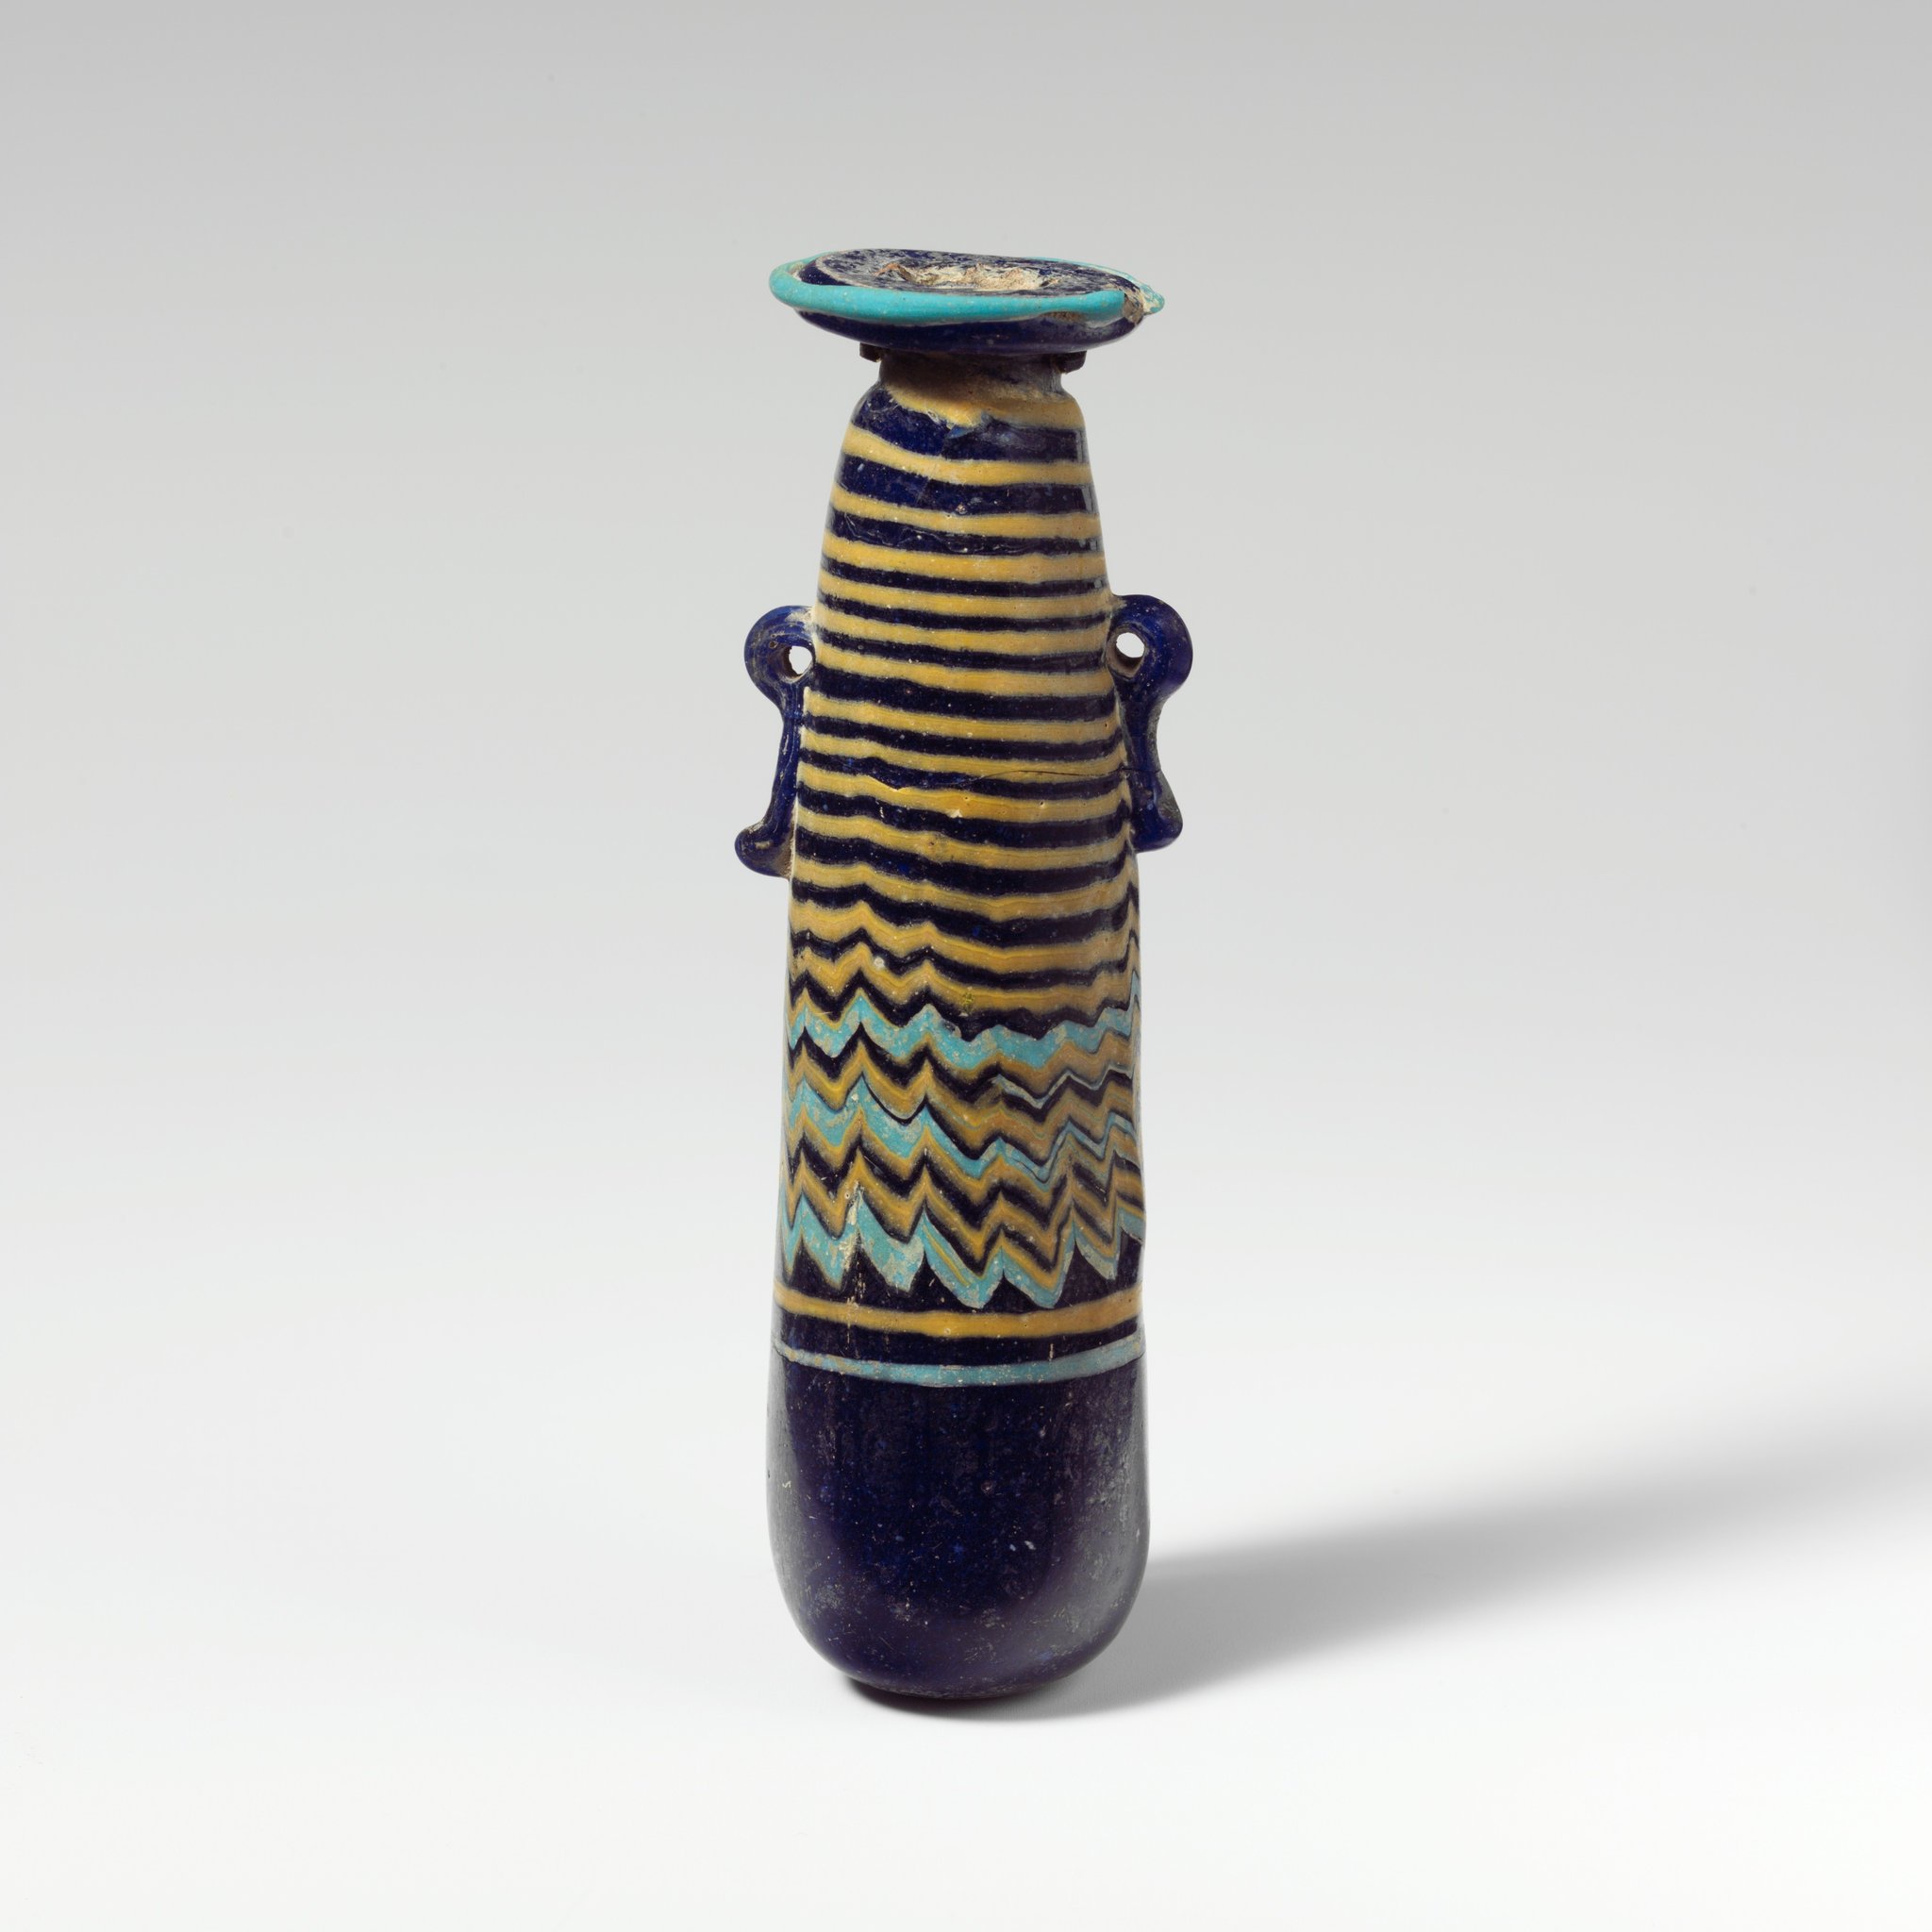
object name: alabastron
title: Glass alabastron (perfume bottle)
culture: greek, eastern mediterranean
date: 534-401 BCE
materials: glass